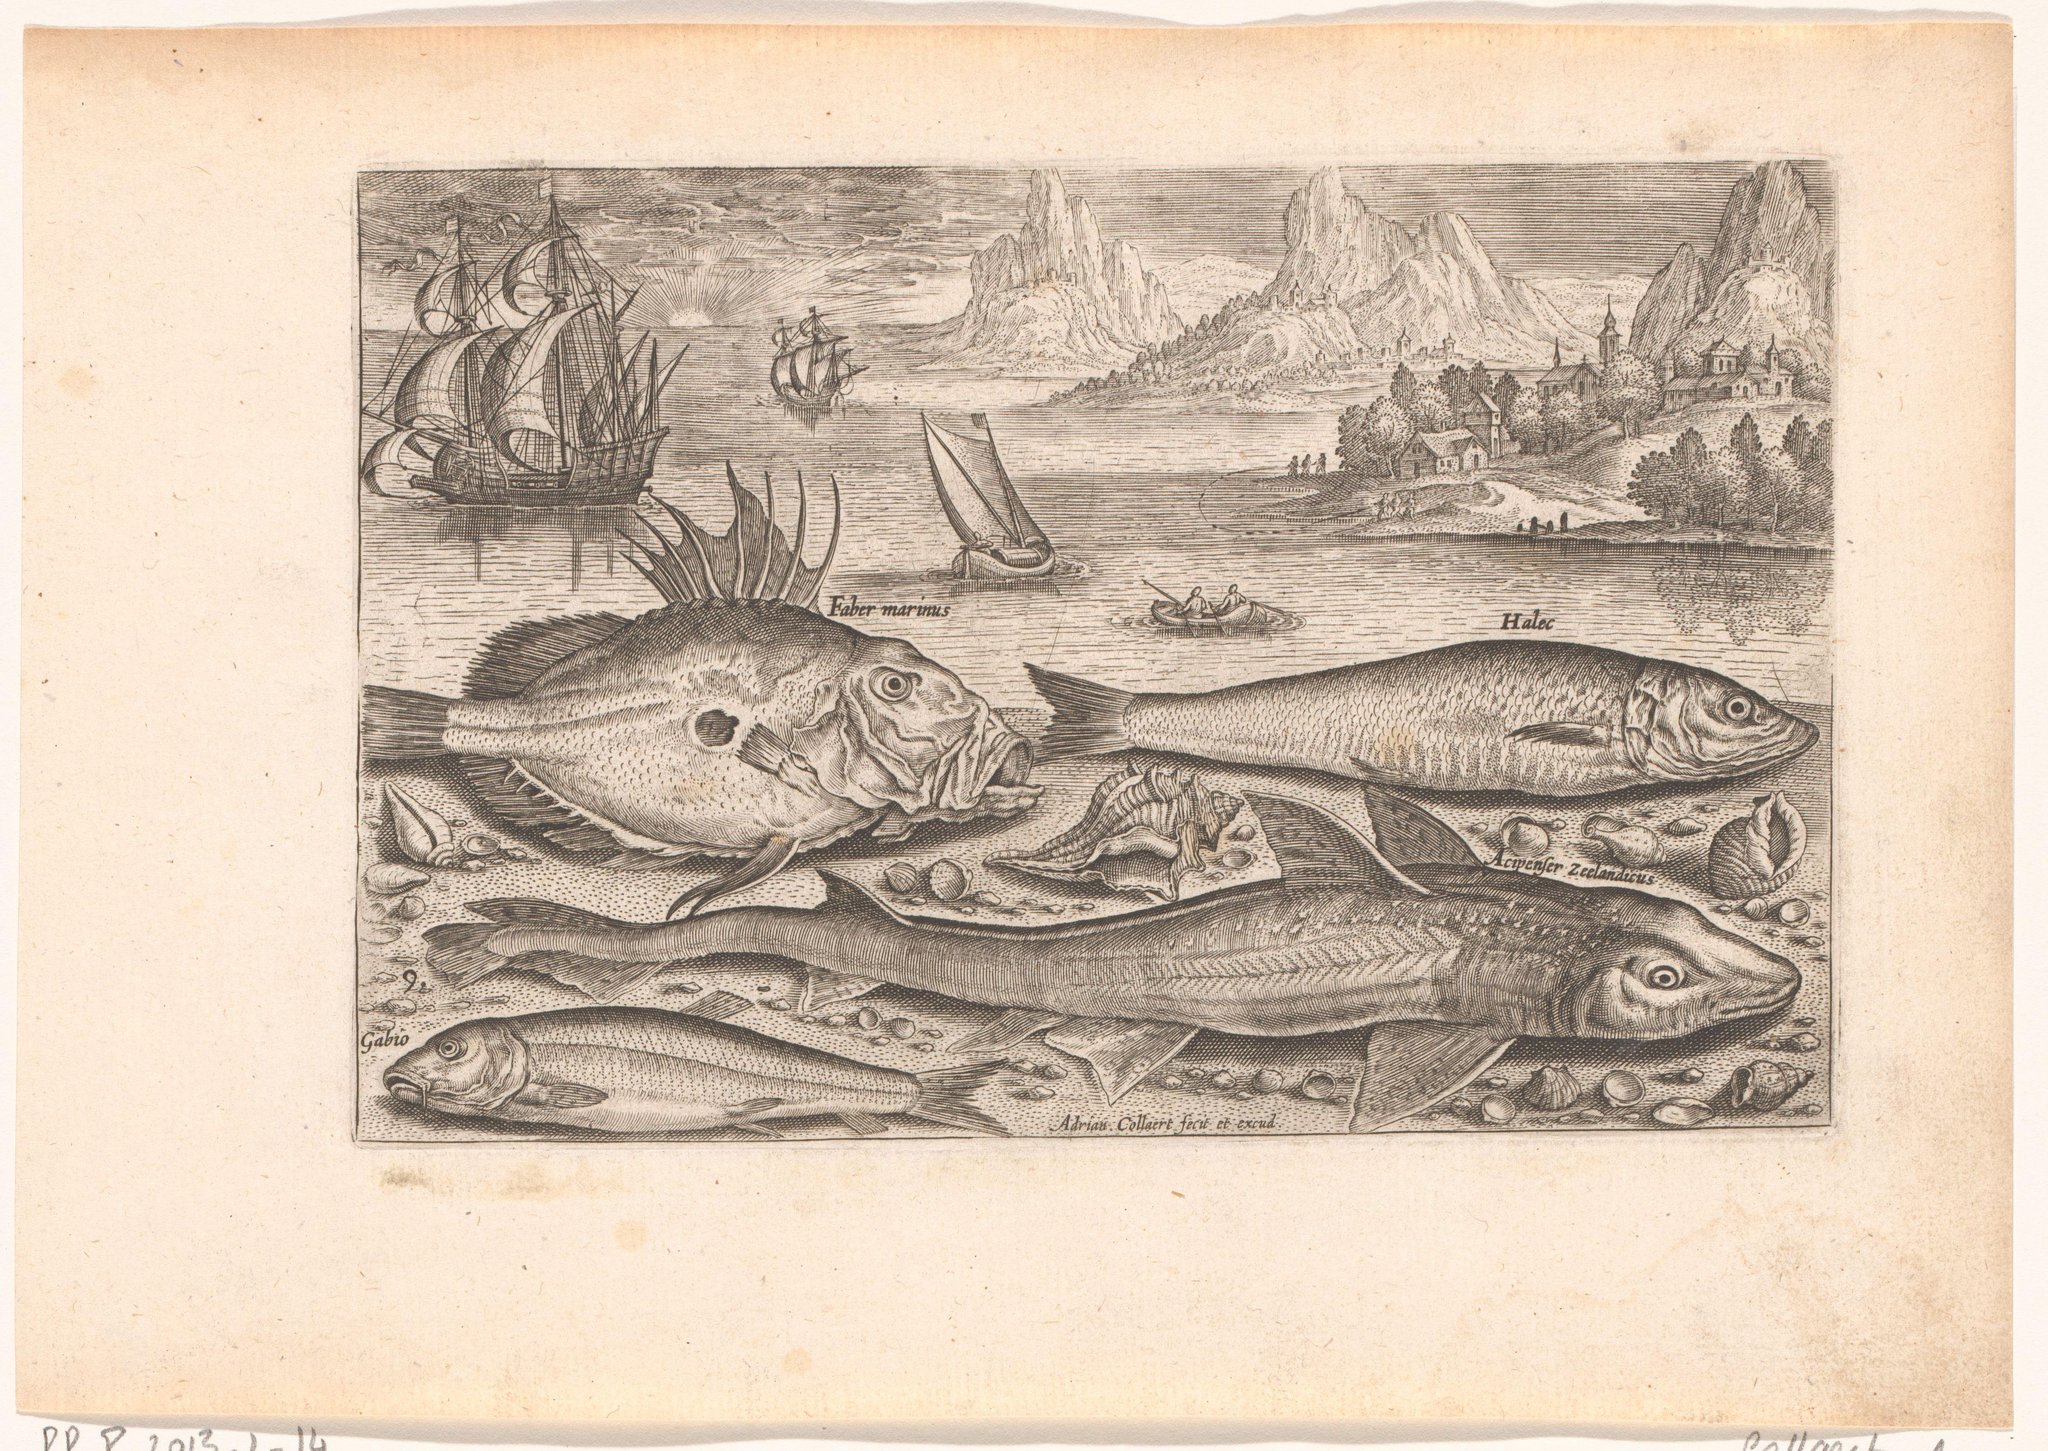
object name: print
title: Piscivm vivae icones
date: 1627-1636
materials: paper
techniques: engraving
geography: antwerp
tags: bony fishes: herring, bony fishes: angelfish, sea (seascape), bony fishes: sturgeon, bony fishes: goby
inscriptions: number: ‘54/17’, collector's mark: Lugt 2228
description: Een grondel, een braam, een steur en een haring liggen samen met wat schelpen aangespoeld op het strand. Op de achtergrond de zee met enkele schepen. De prent maakt deel uit van een serie met vissen als onderwerp.